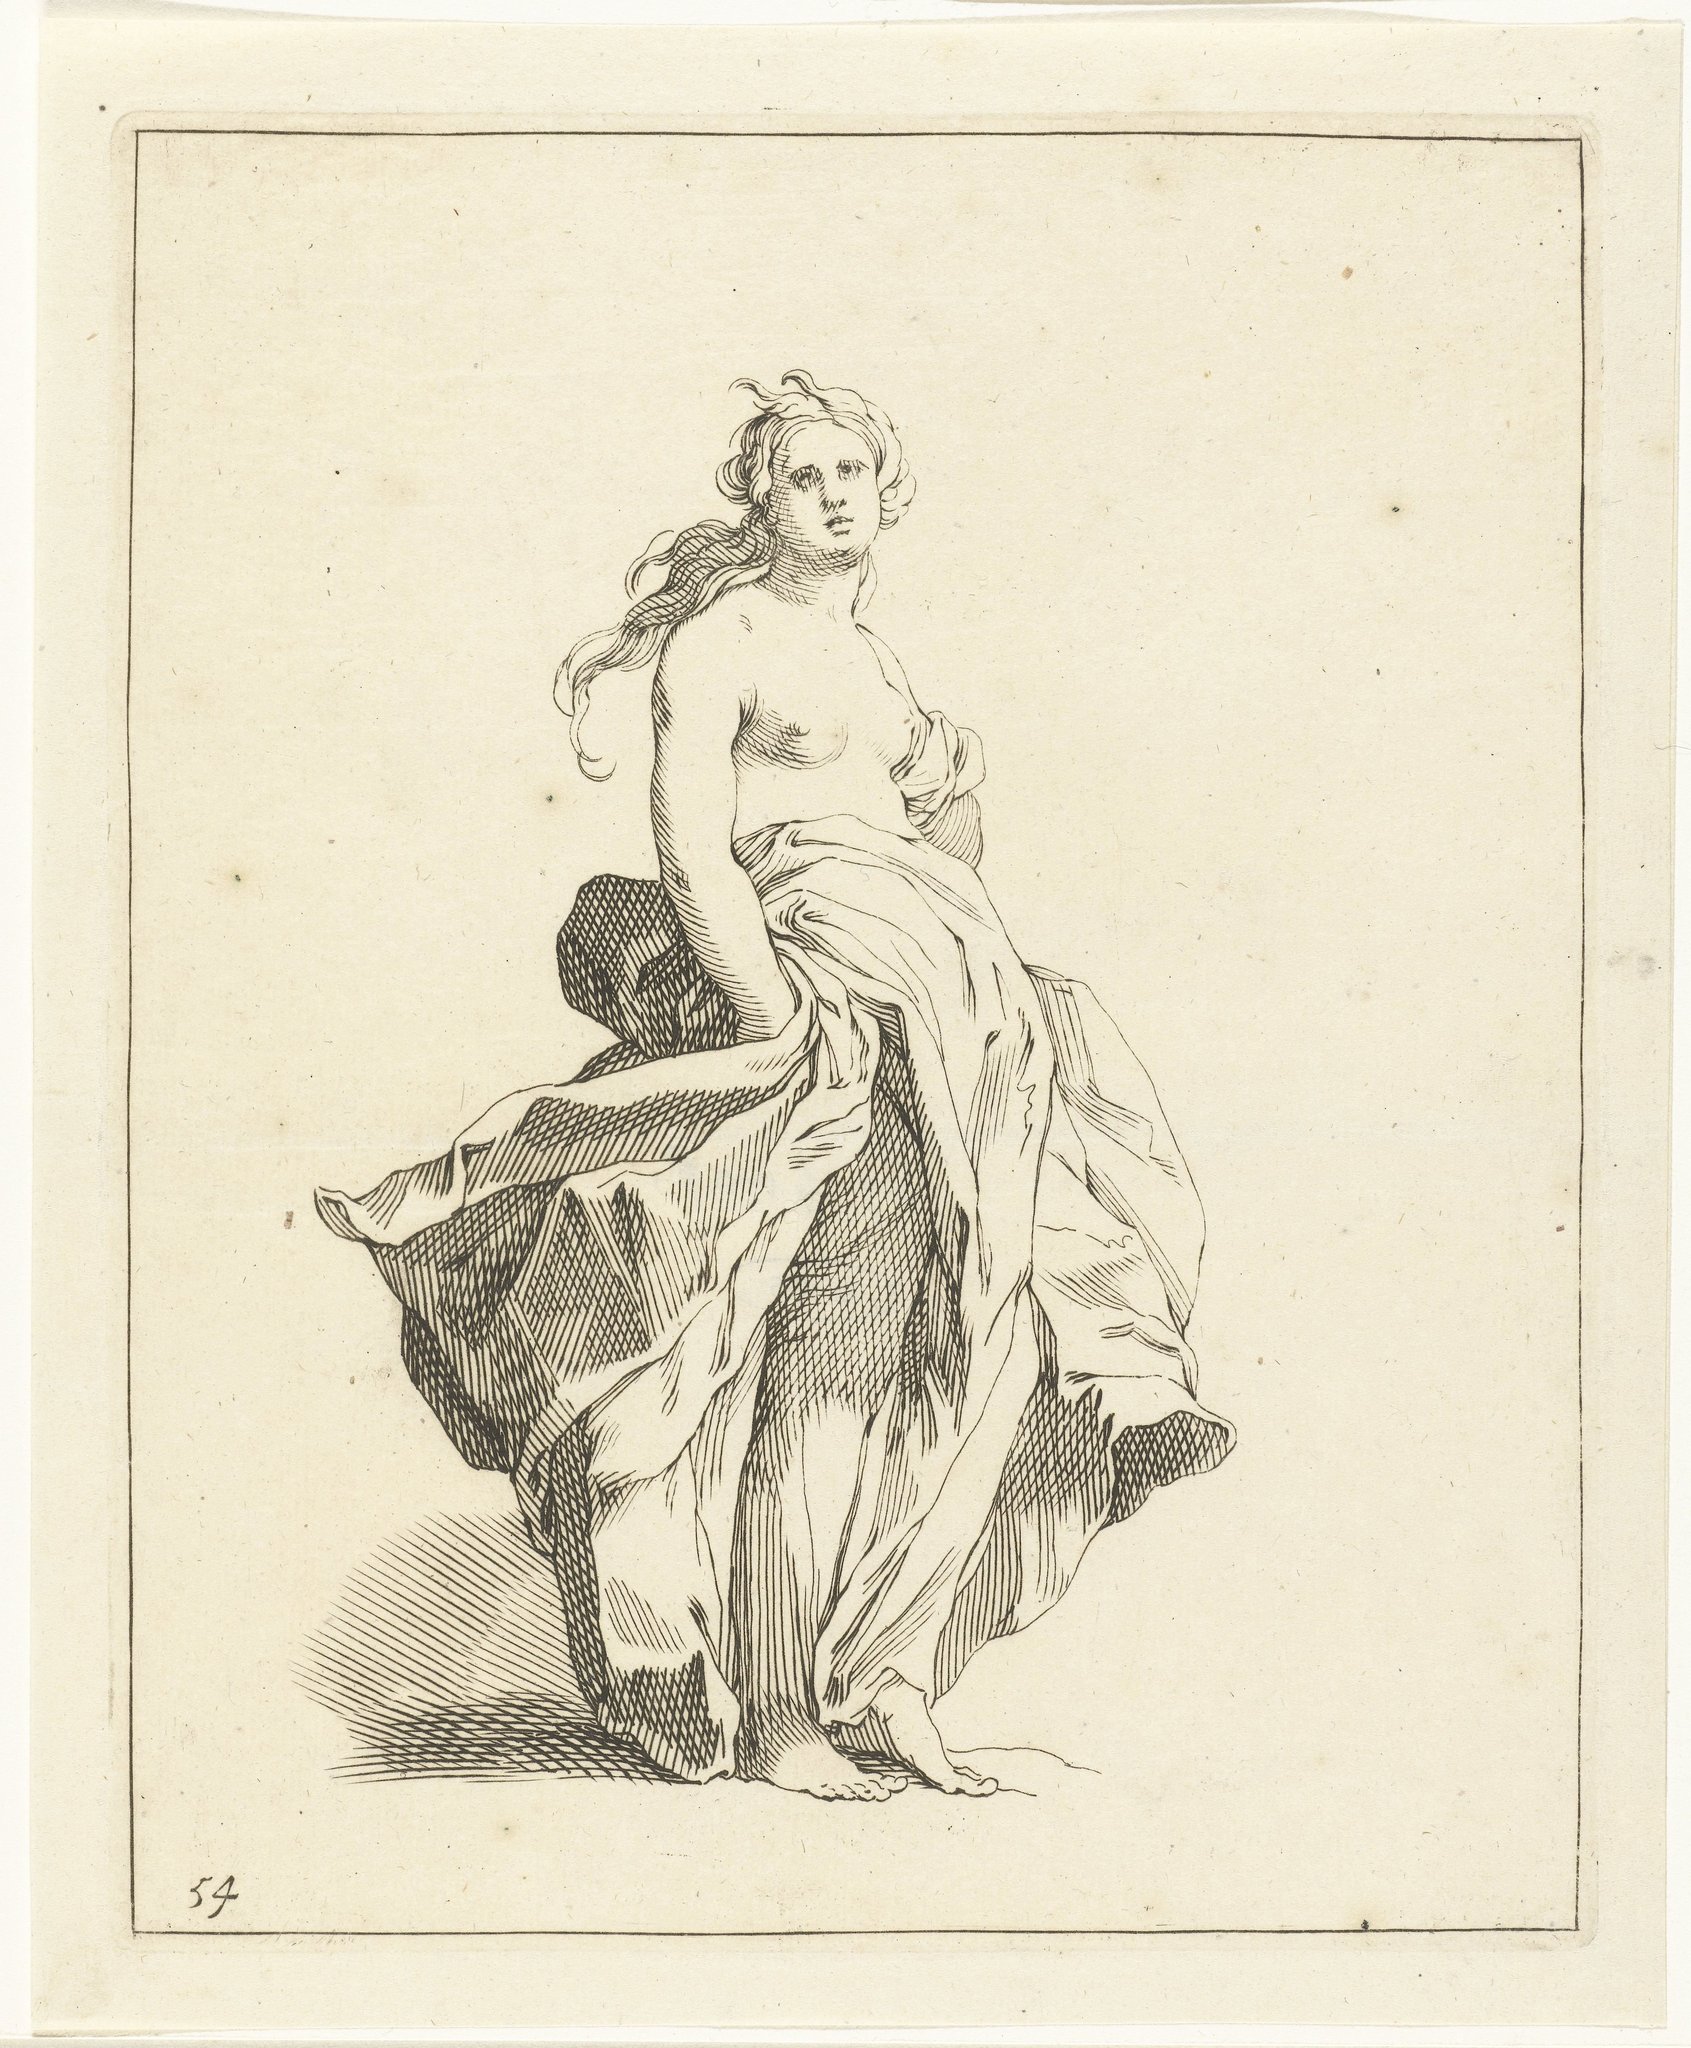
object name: print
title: Het tekenboek van Abraham Bloemaert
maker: frederick bloemaert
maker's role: print maker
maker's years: 1614-1669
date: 1650-1700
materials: paper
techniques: engraving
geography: utrecht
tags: adult woman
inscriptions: collector's mark: Lugt 2228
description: Een staande vrouw met ontbloot bovenlichaam, om haar middel een ruim gedrapeerd kleed gewikkeld.